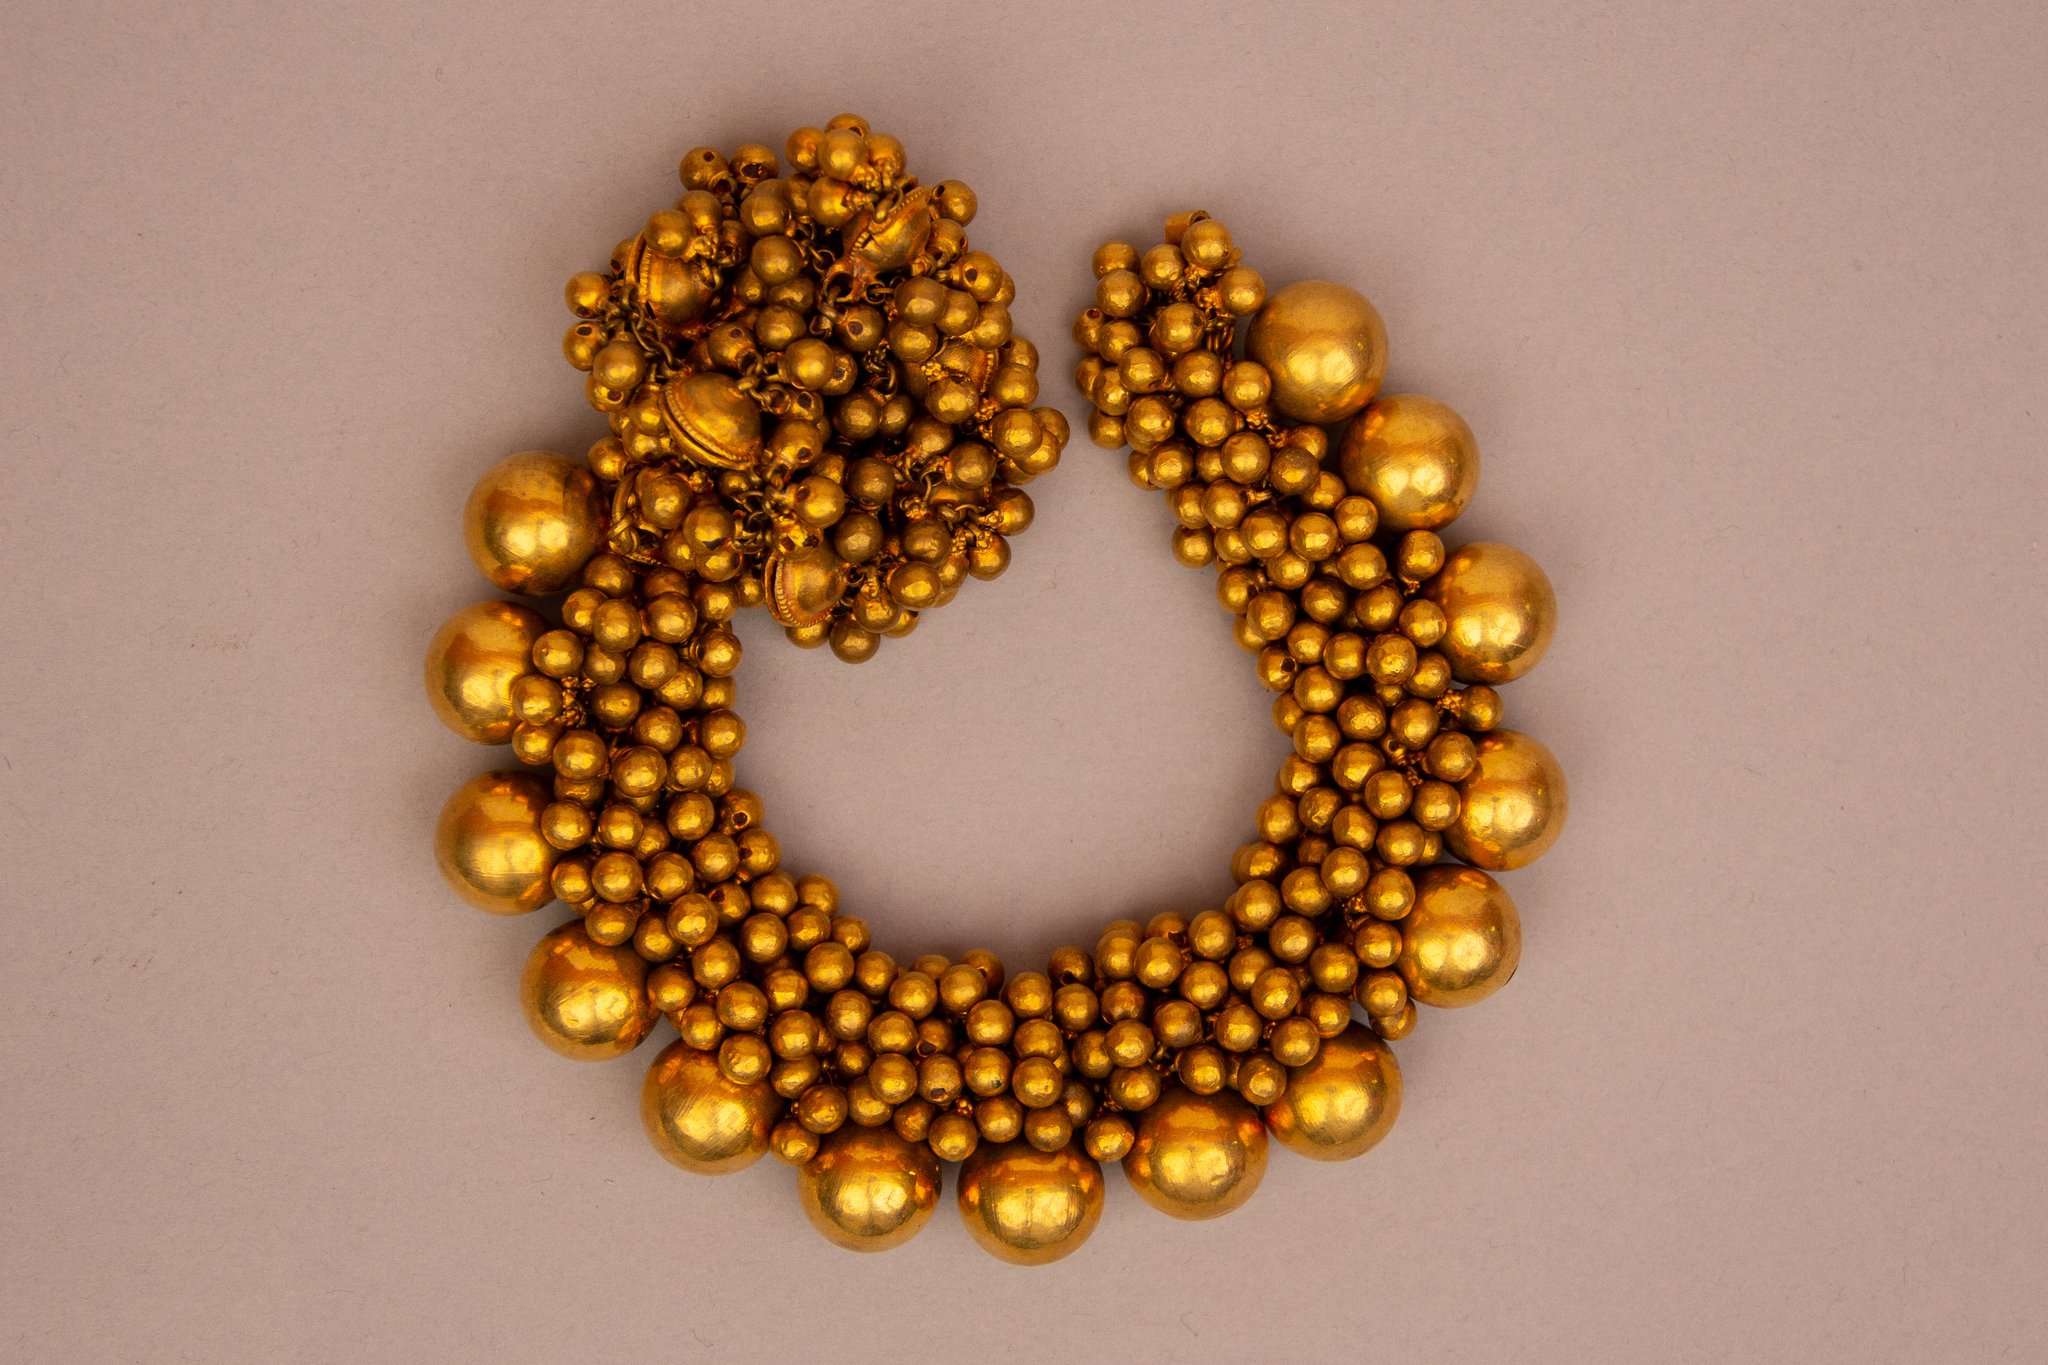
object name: anklet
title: Anklet, One of a Pair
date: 1801-1900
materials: gold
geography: india